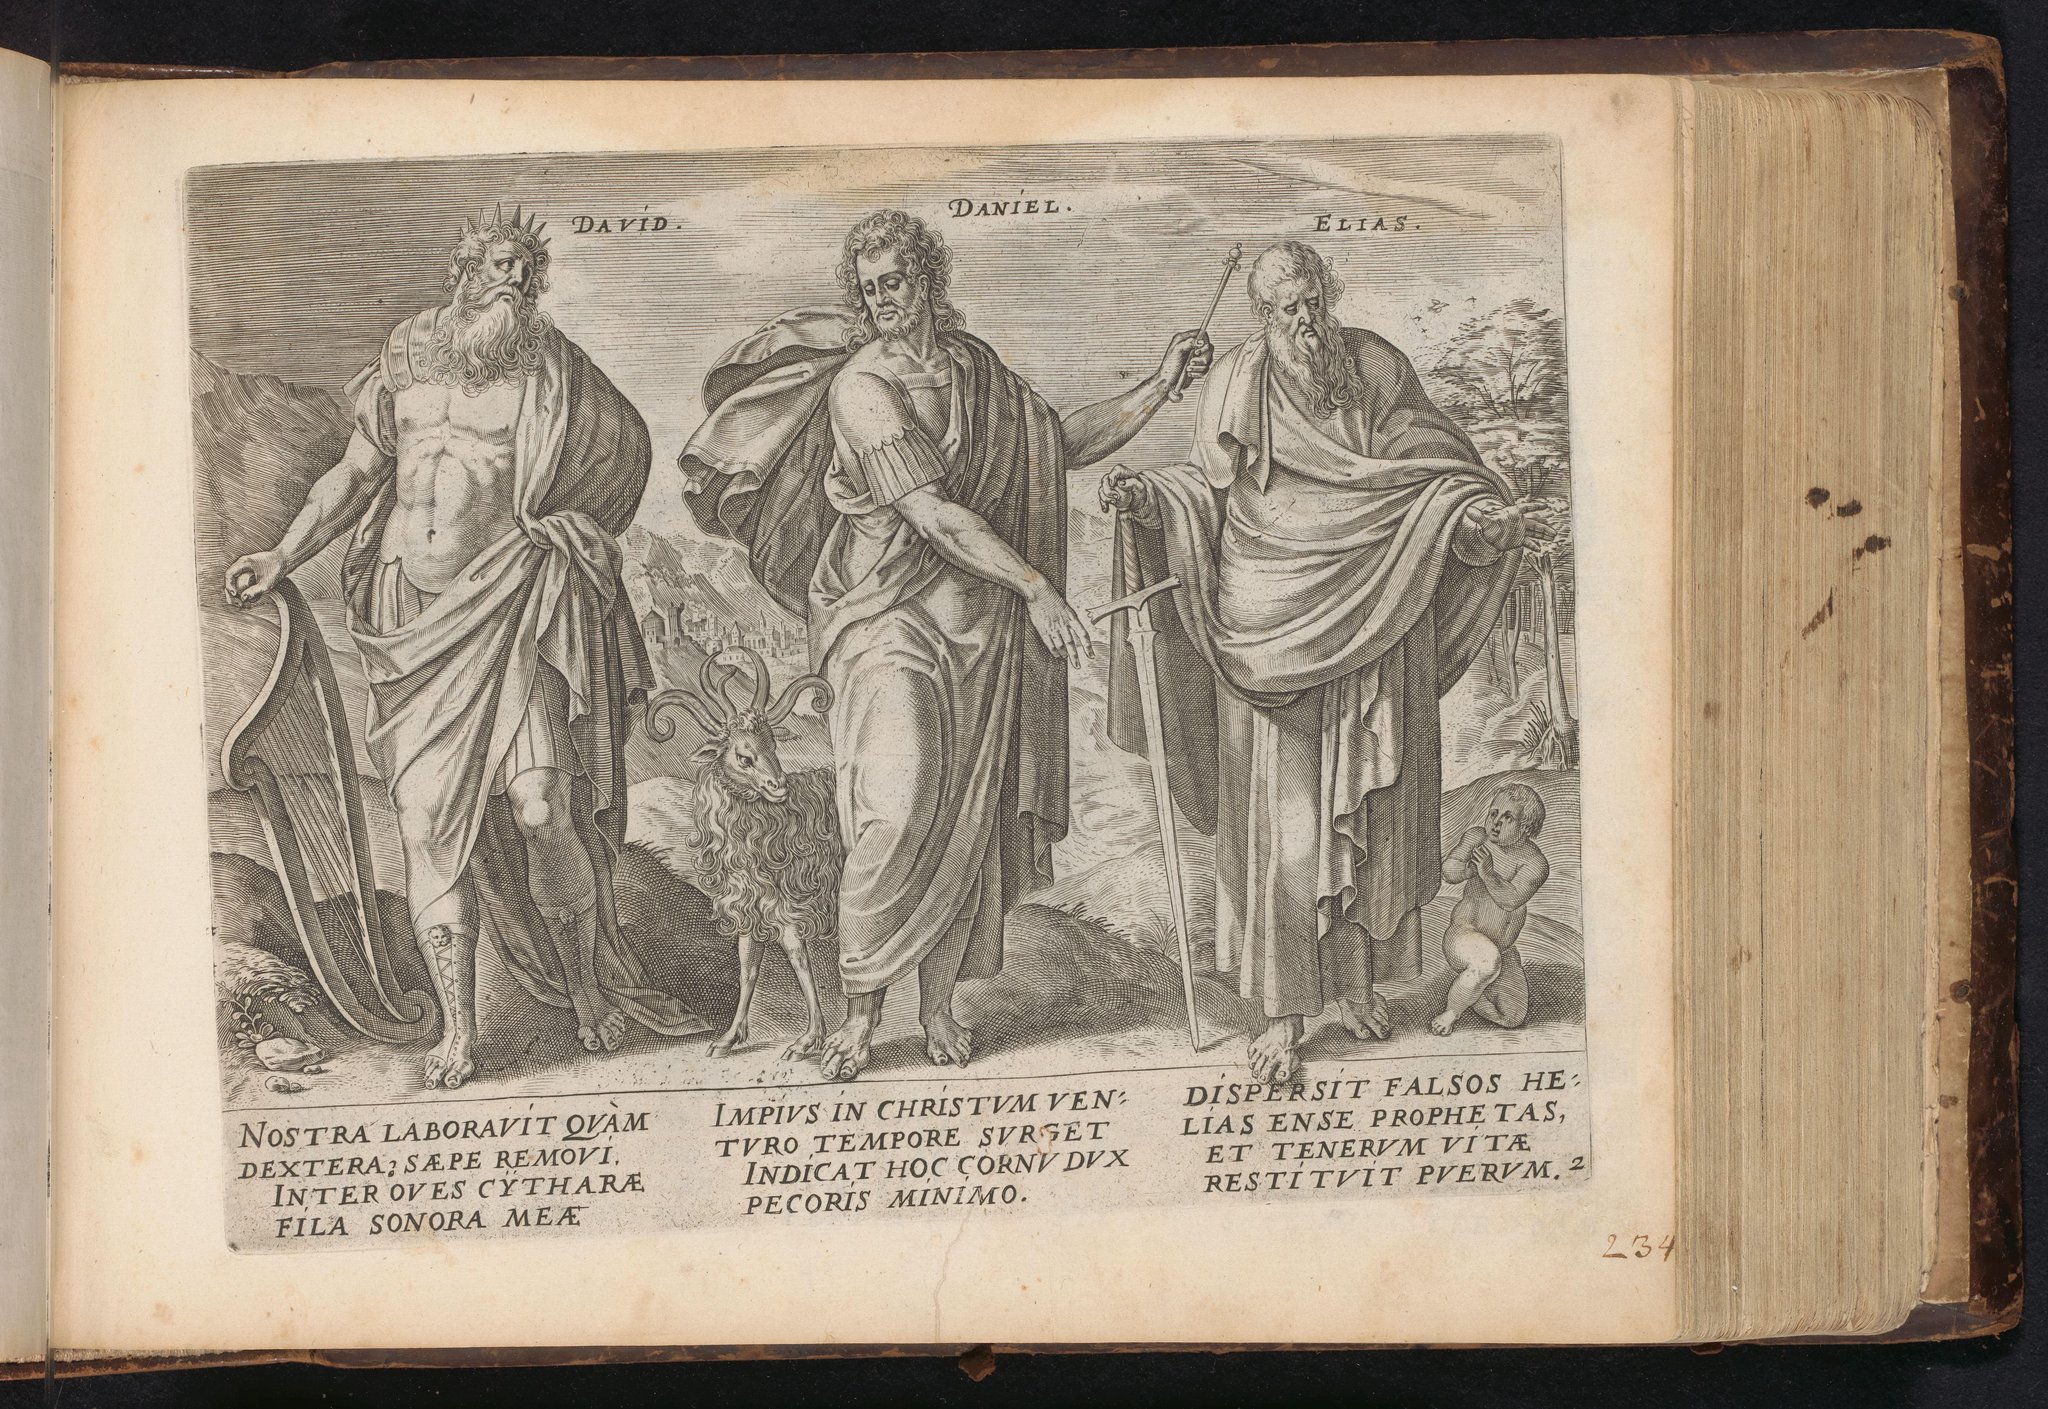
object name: print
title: Den Grooten Figuer-Bibel (...)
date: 1579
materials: paper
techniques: engraving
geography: amsterdam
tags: daniel (not in biblical context); possible attributes: phrygian bonnet, lion(s), ram - other activities, relationships, etc. of male persons from the old testament, david as prophet, with crown and scroll, groups of prophets, usually holding books or scrolls (isaiah, jeremiah, ezekiel, daniel, hosea, joel, amos, obadiah, jonah, micah, nahum, habakkuk, zephaniah, haggai, zechariah, malachi), elijah (not in biblical context); possible attributes: scroll and flaming sword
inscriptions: number: ‘234’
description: De profeten David, Daniël en Elia staan naast elkaar in een landschap. Koning David met kroon en harp, Daniël met staf en naast hem een bok, Elia met zwaard en een knielend kind naast zich. Onder de voorstelling toelichtingen in het Latijn. Deze prent maakt deel uit van een album.